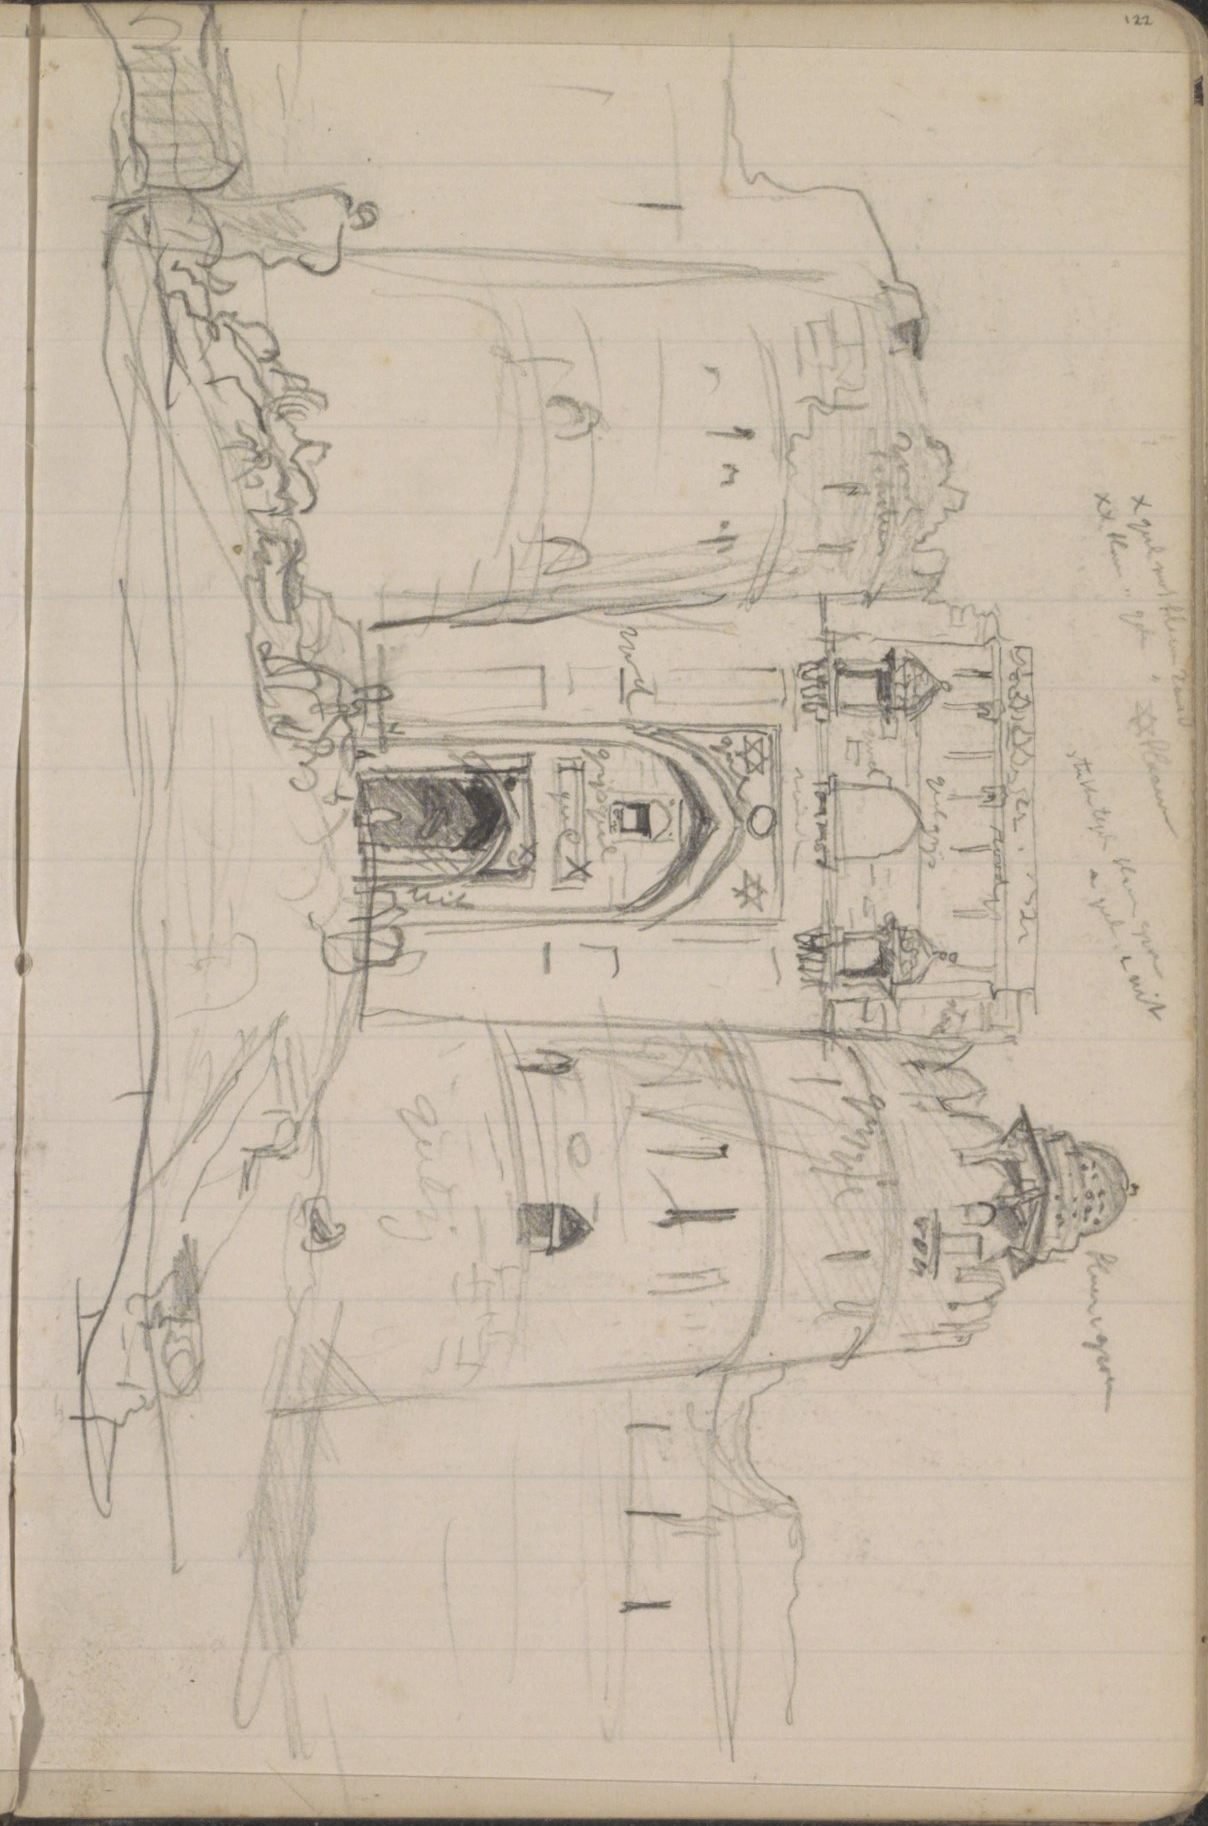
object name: sketchbook leaf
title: Poort en torens van het fort Indrapat in Delhi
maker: marius bauer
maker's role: draughtsman, print maker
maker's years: 1867-1932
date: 1897-1898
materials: pencil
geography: delhi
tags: gate ~ fortified city, towers ~ fortified city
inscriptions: kleurnotitie, handgeschreven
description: Pagina 122 uit een schetsboek met 84 bladen.